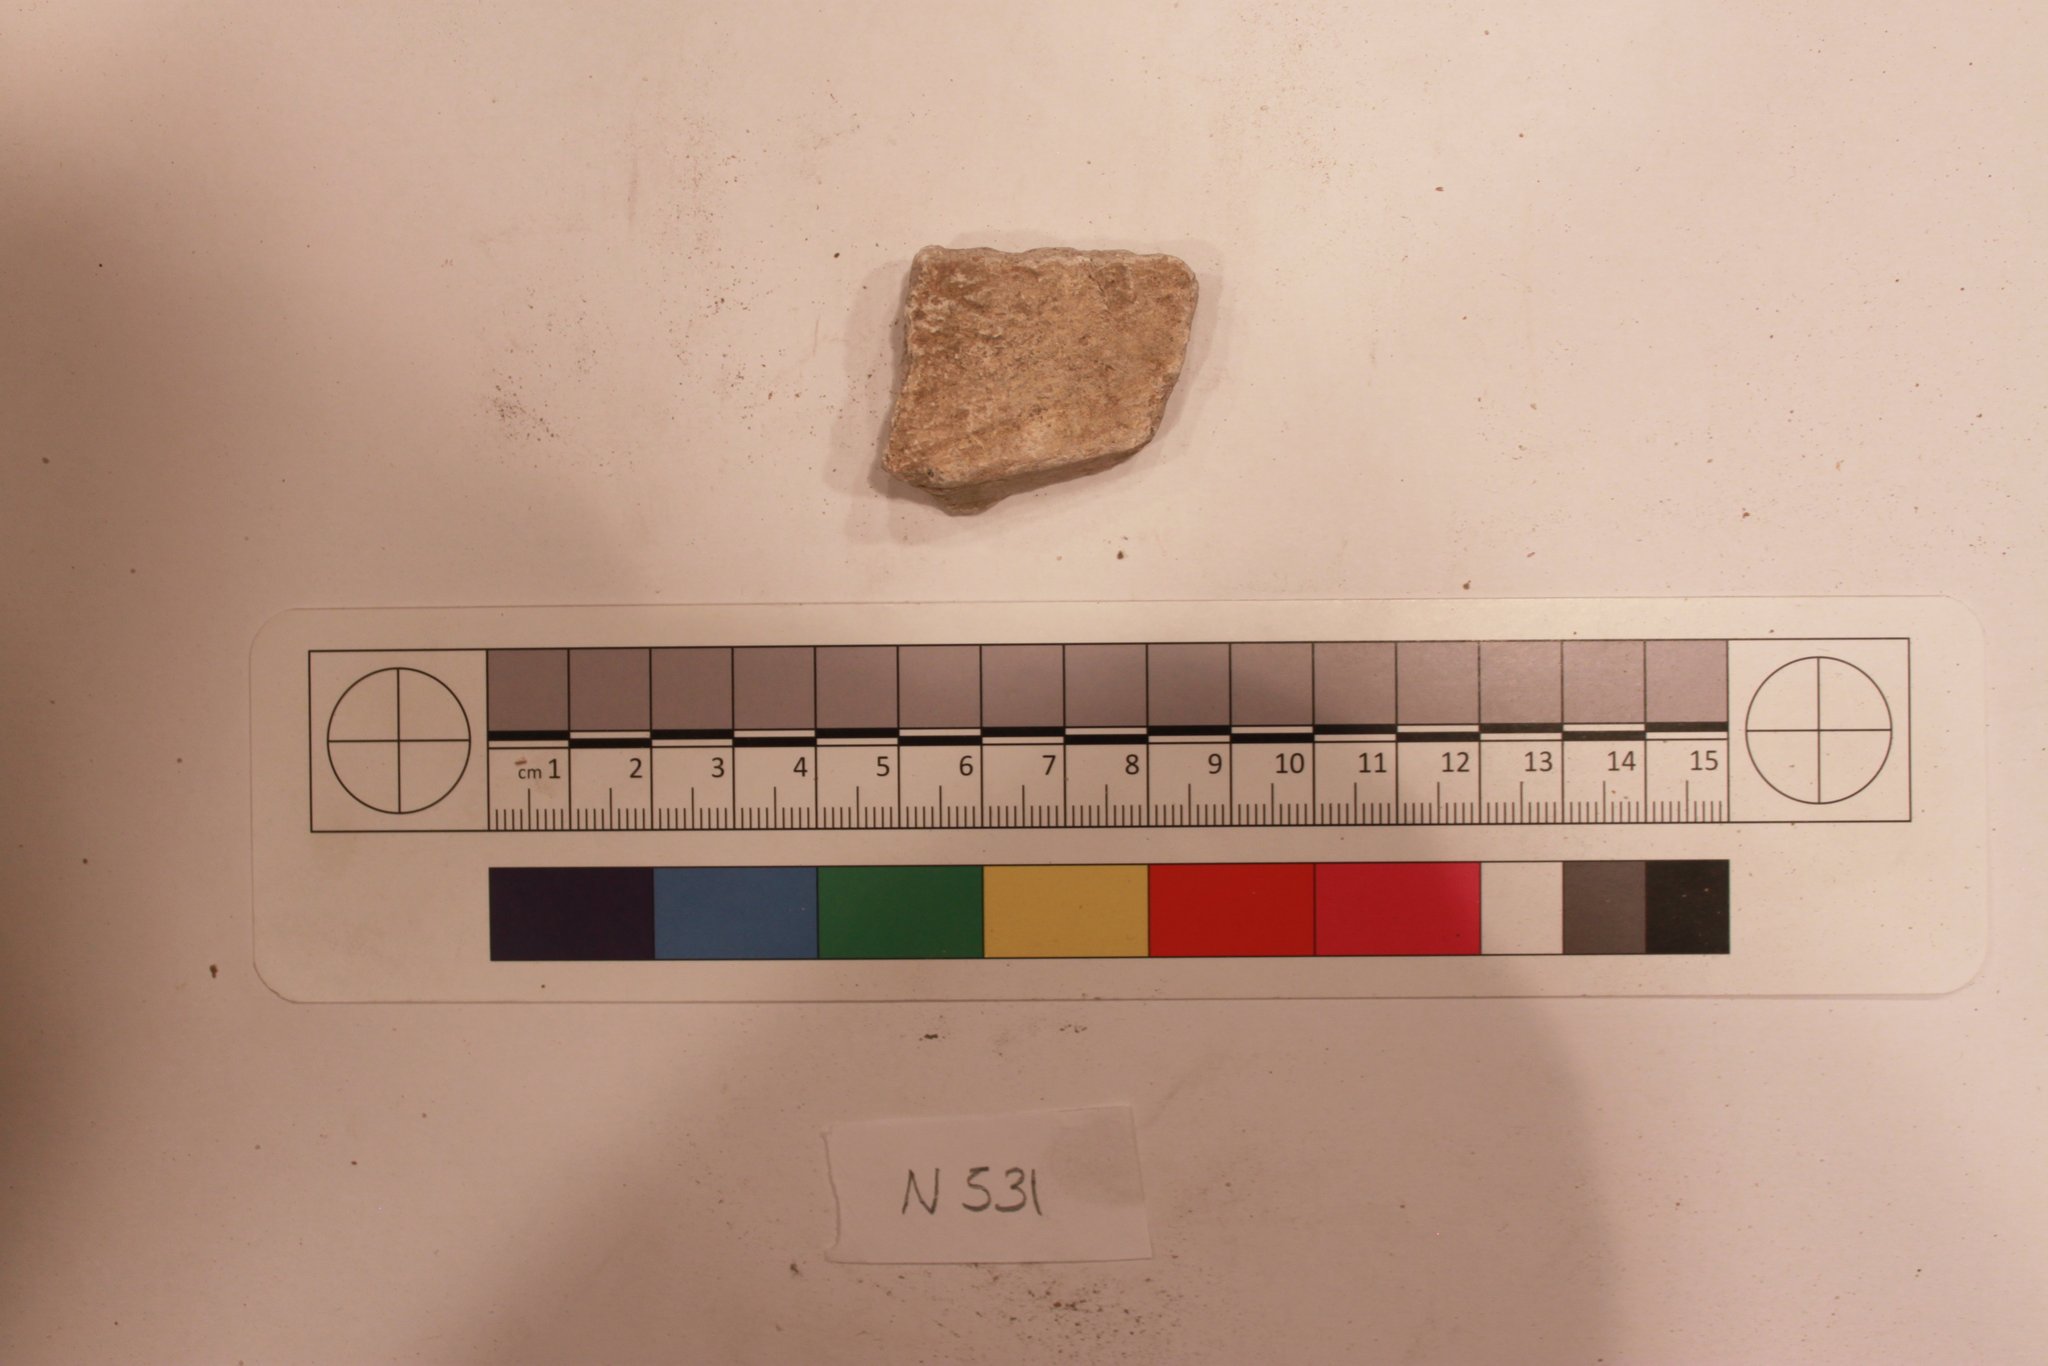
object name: fragment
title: Stucco Fragment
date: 701-1200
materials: plaster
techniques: carving, painting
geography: iran